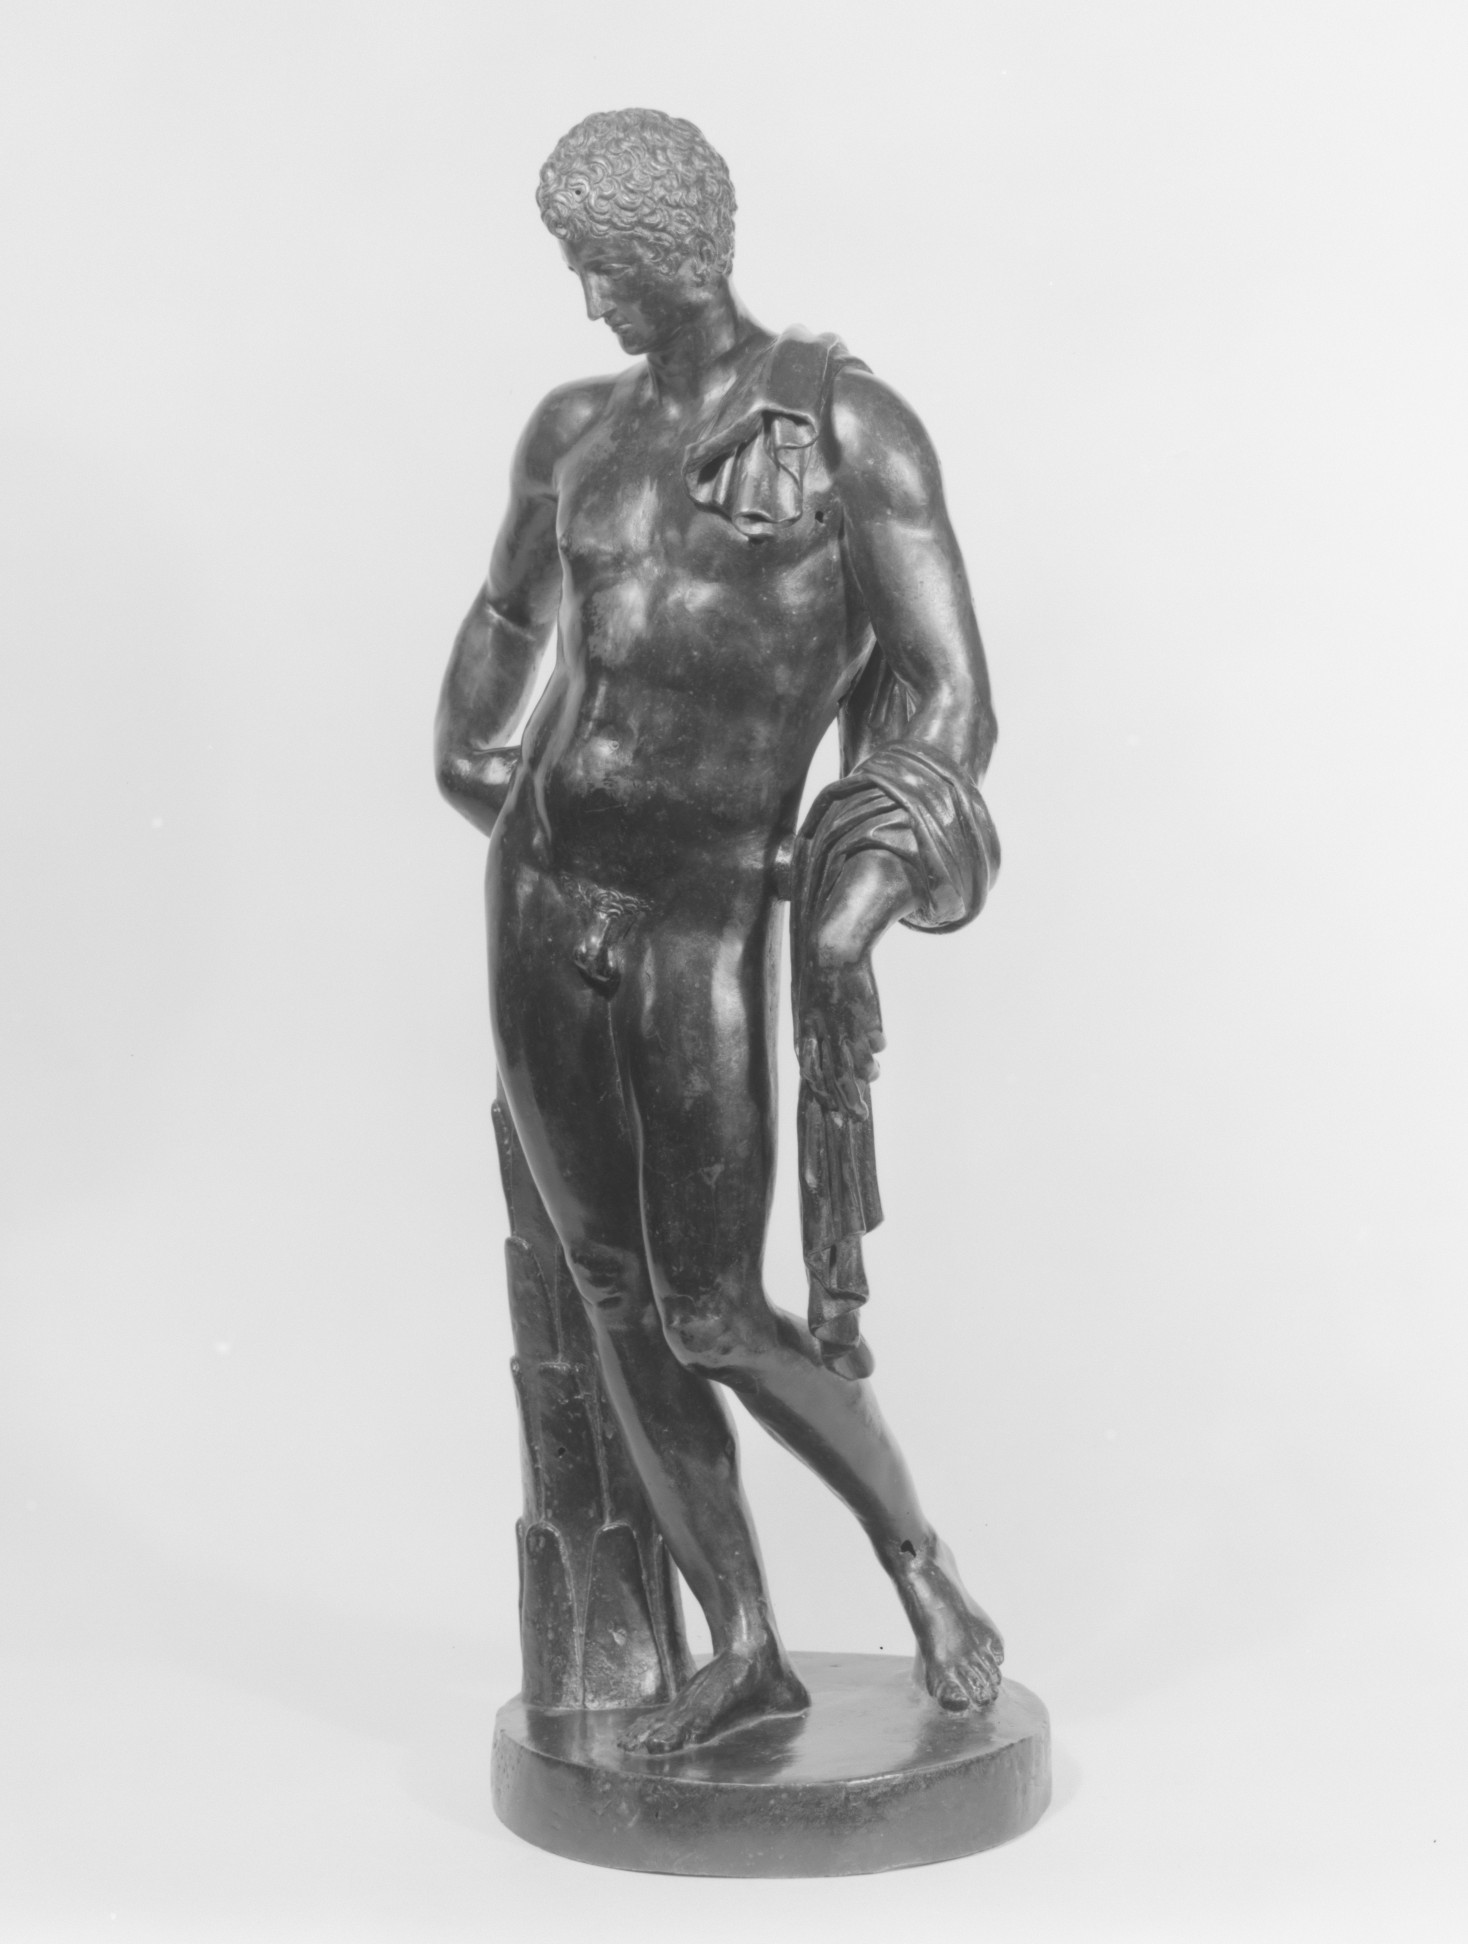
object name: statuette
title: Antinous Belvedere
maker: willem danielsz van tetrode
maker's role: artist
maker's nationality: netherlandish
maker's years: 1525-1580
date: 1801-2000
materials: bronze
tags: male nudes